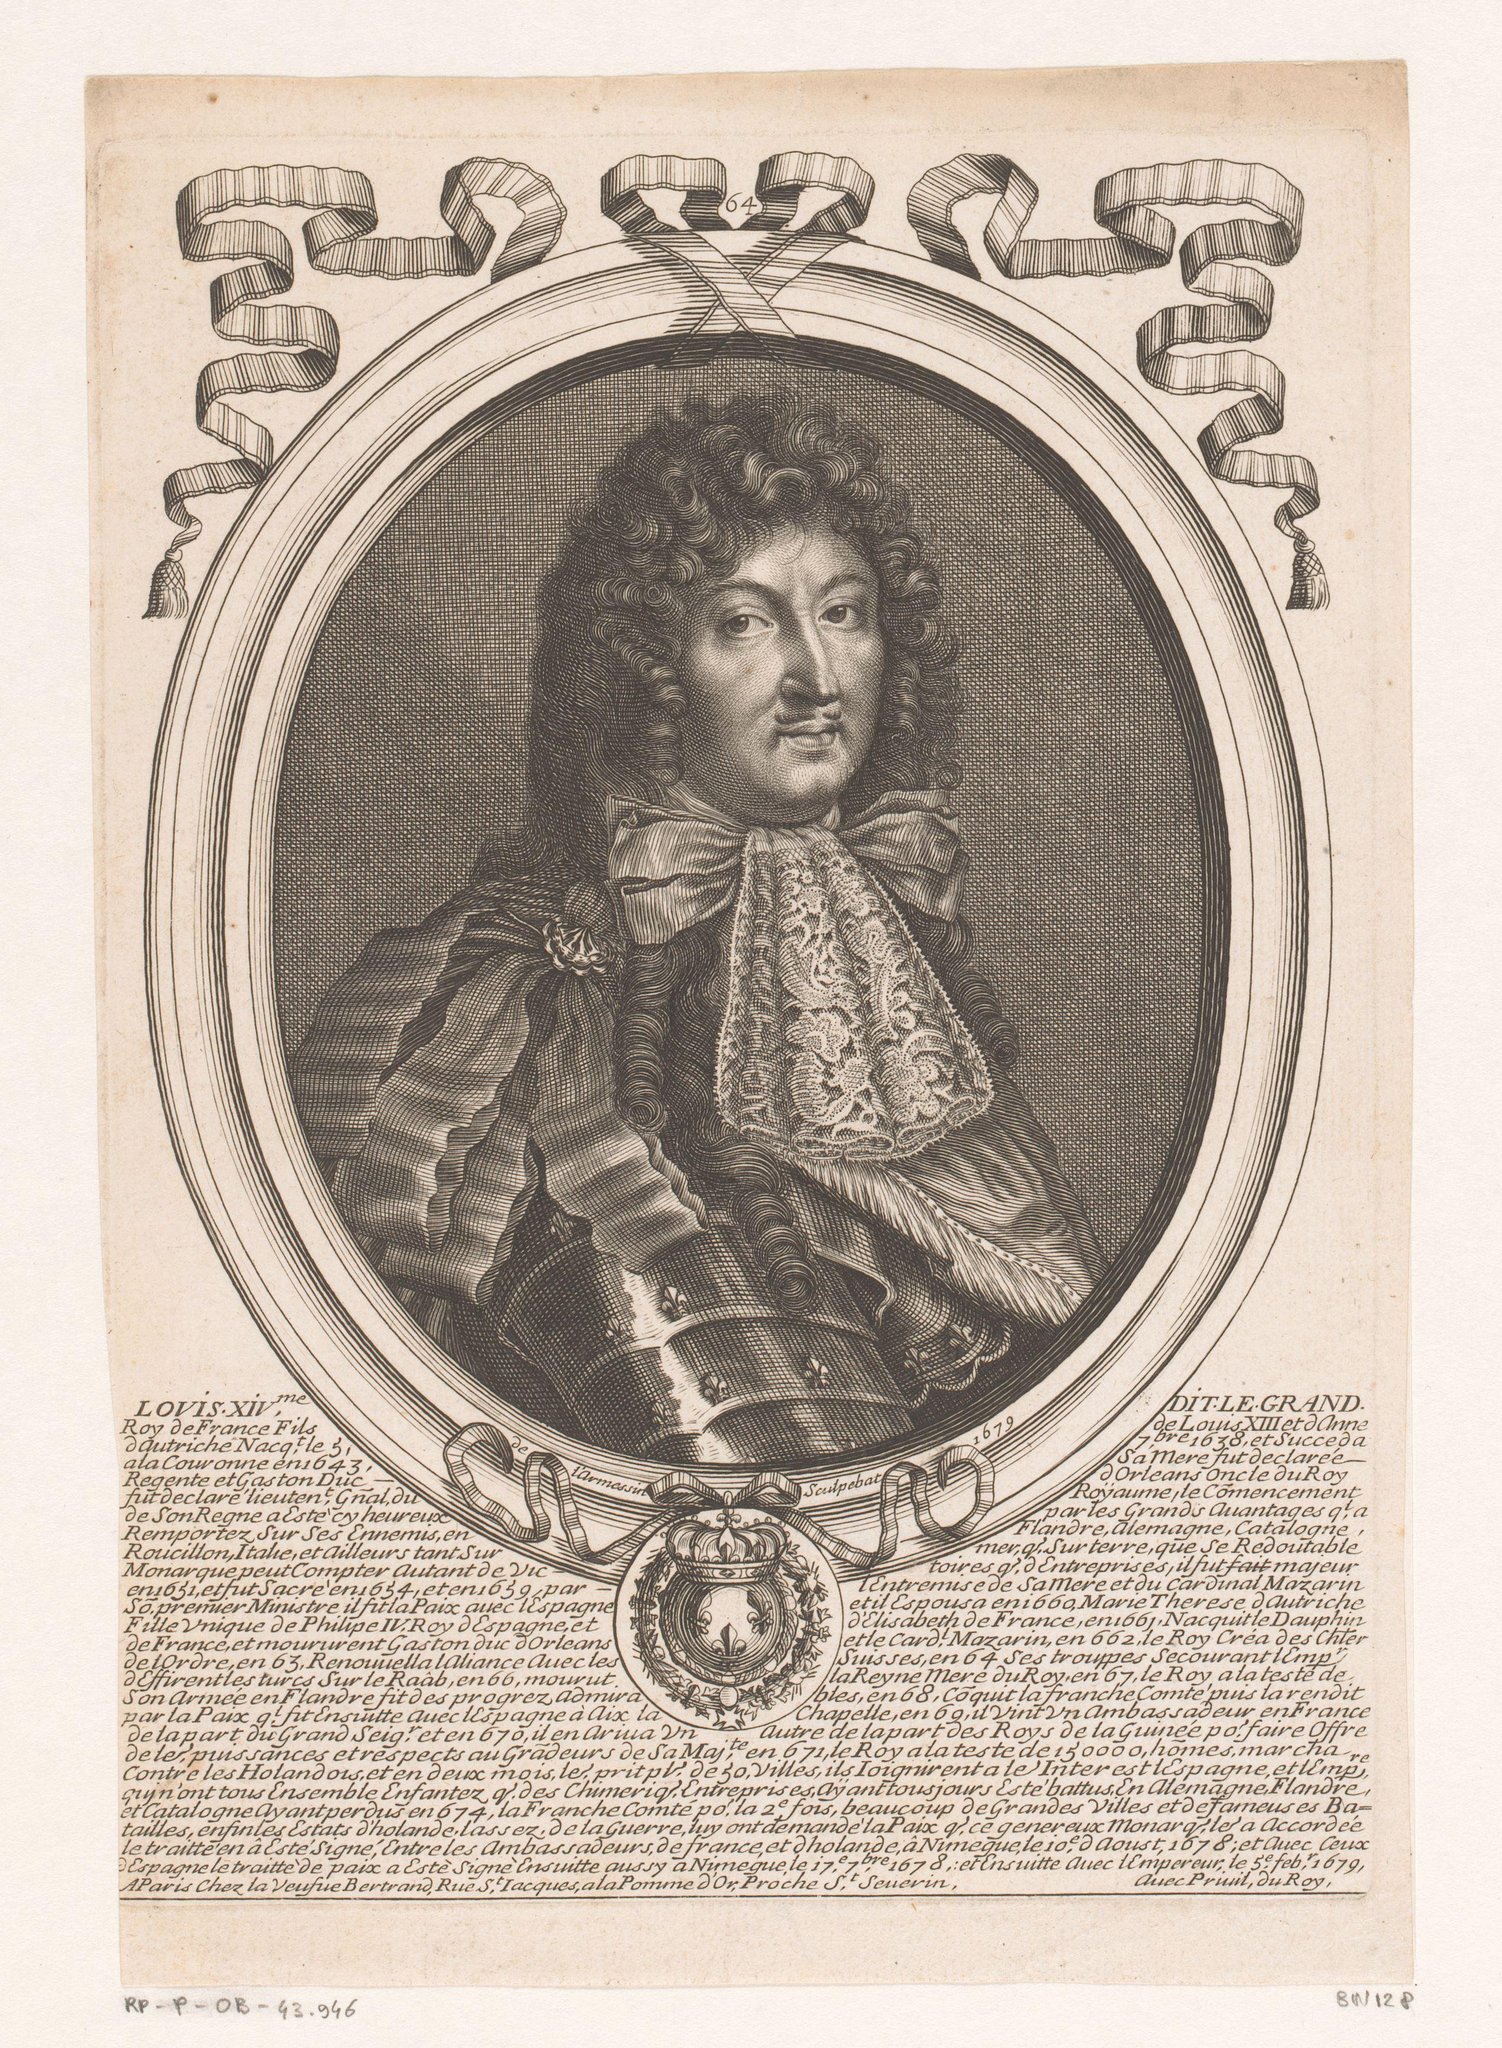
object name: print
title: Portret van Lodewijk XIV, koning van Frankrijk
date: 1679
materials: paper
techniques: engraving, etching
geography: france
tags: lodewijk xiv (koning van frankrijk), historical persons, king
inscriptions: collector's mark: Lugt 2228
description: Maakt deel uit van een grootschalige serie met portretten van prominente figuren. Binnen de serie bevindt zich een sectie getiteld 'Les Augustes Représentations De tous les Roys De France depuis Pharamond Iusqu'à Louys XIIII'. De serie werd respectievelijk uitgegeven door Pierre Bertrand, door zijn weduwe en door De Larmessin zelf.